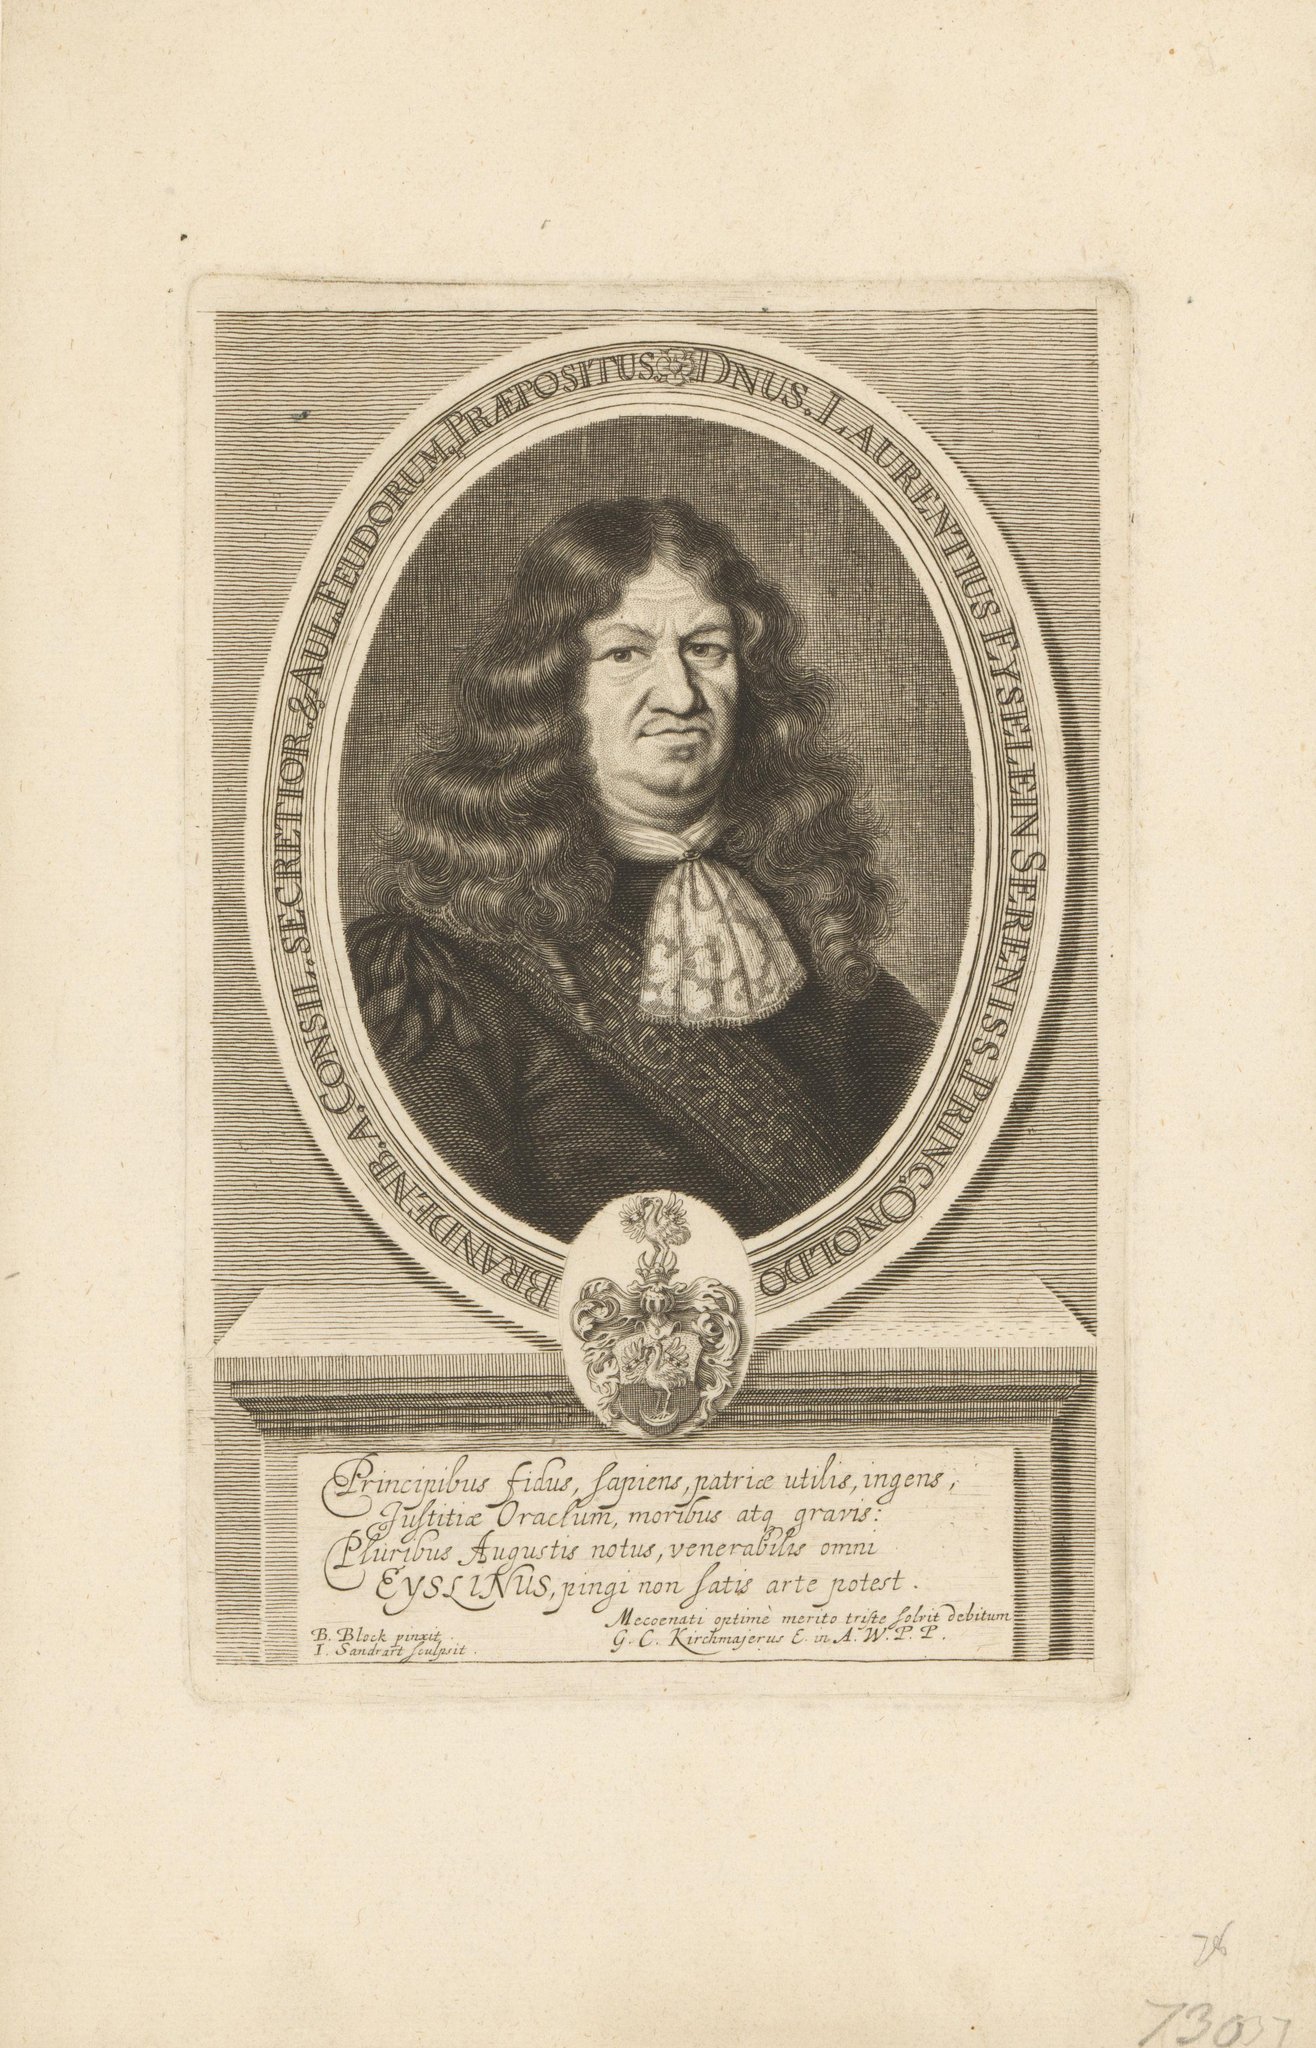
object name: print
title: Portret van Lorenz Eyselein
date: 1678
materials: paper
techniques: engraving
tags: historical persons, armorial bearing, heraldry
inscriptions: collector's mark: Lugt 2228